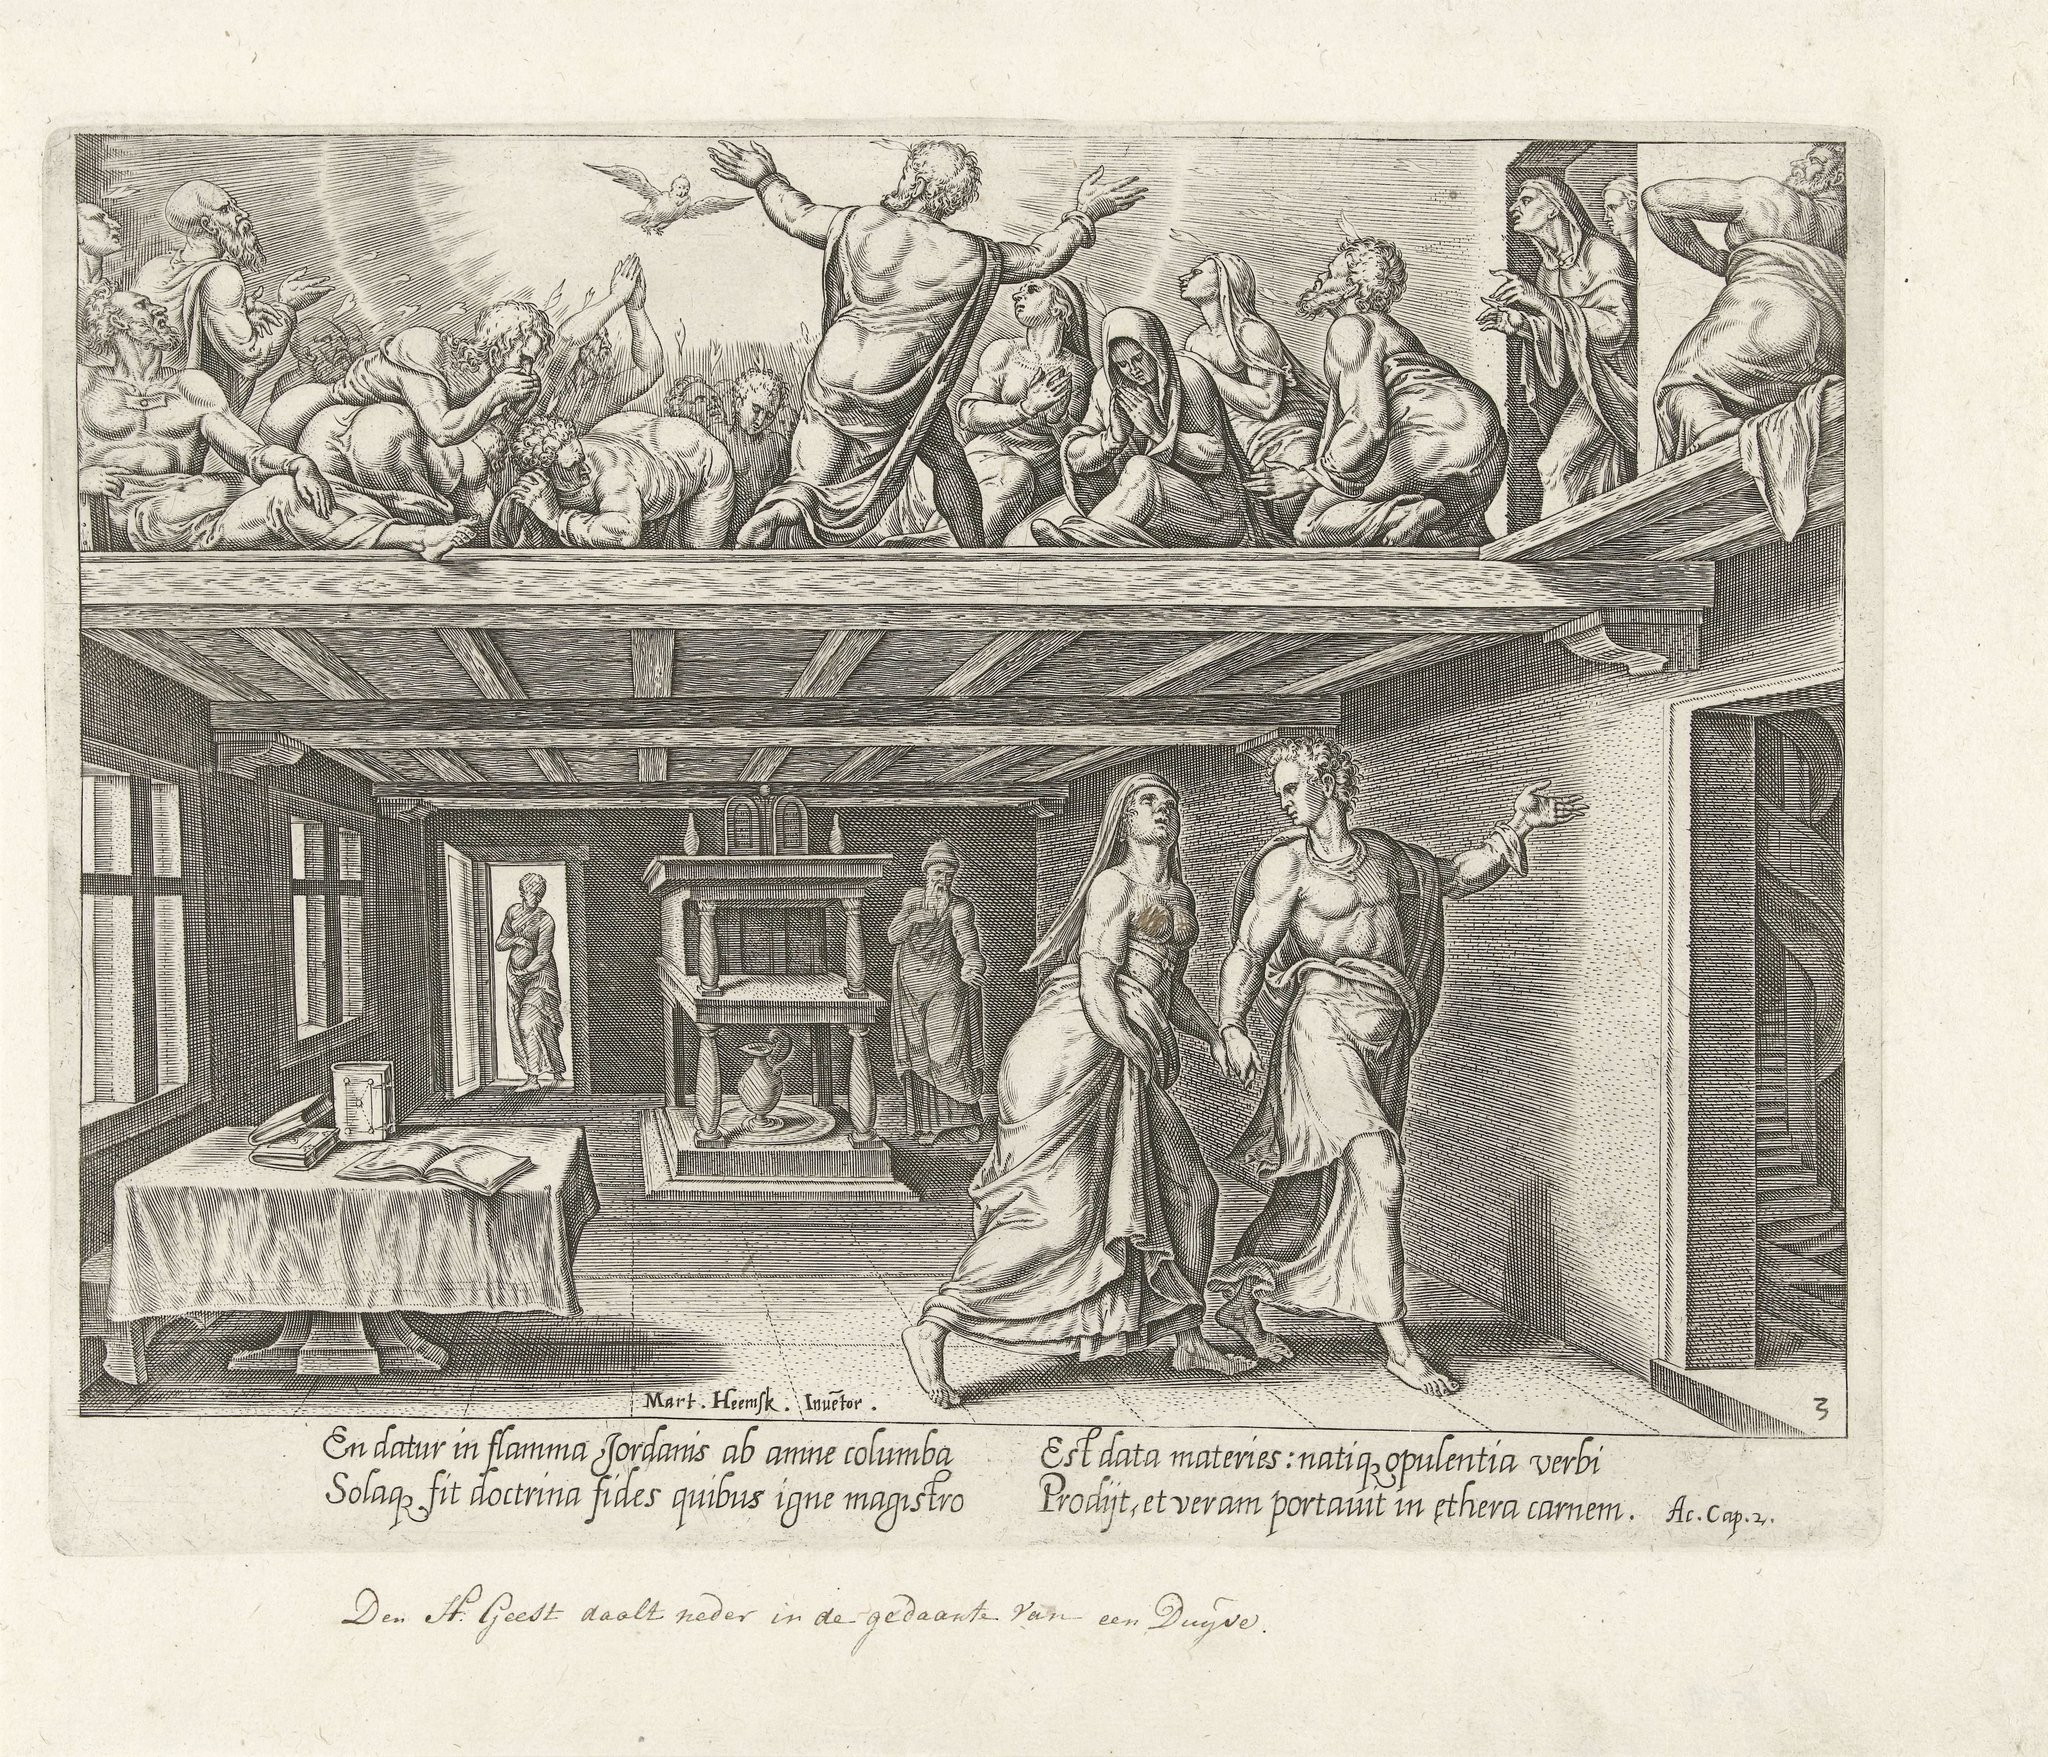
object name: print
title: Acta Apostolorum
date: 1575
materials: paper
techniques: brush, engraving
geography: antwerp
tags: pentecost: the holy ghost descends upon (mary and) the apostles, sometimes paul and/or representatives of the nations present (acts 2:1-4)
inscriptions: caption: ‘Den H. Geest daalt neder in de gedaante van een Duyve’, collector's mark: Lugt 2228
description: Op de bovenste verdieping de leerlingen van Christus. Boven hen zweeft de duif van de Heilige Geest. De prent heeft een Latijns onderschrift en maakt deel uit van een 34-delige serie met als onderwerp de Handelingen van de apostelen.